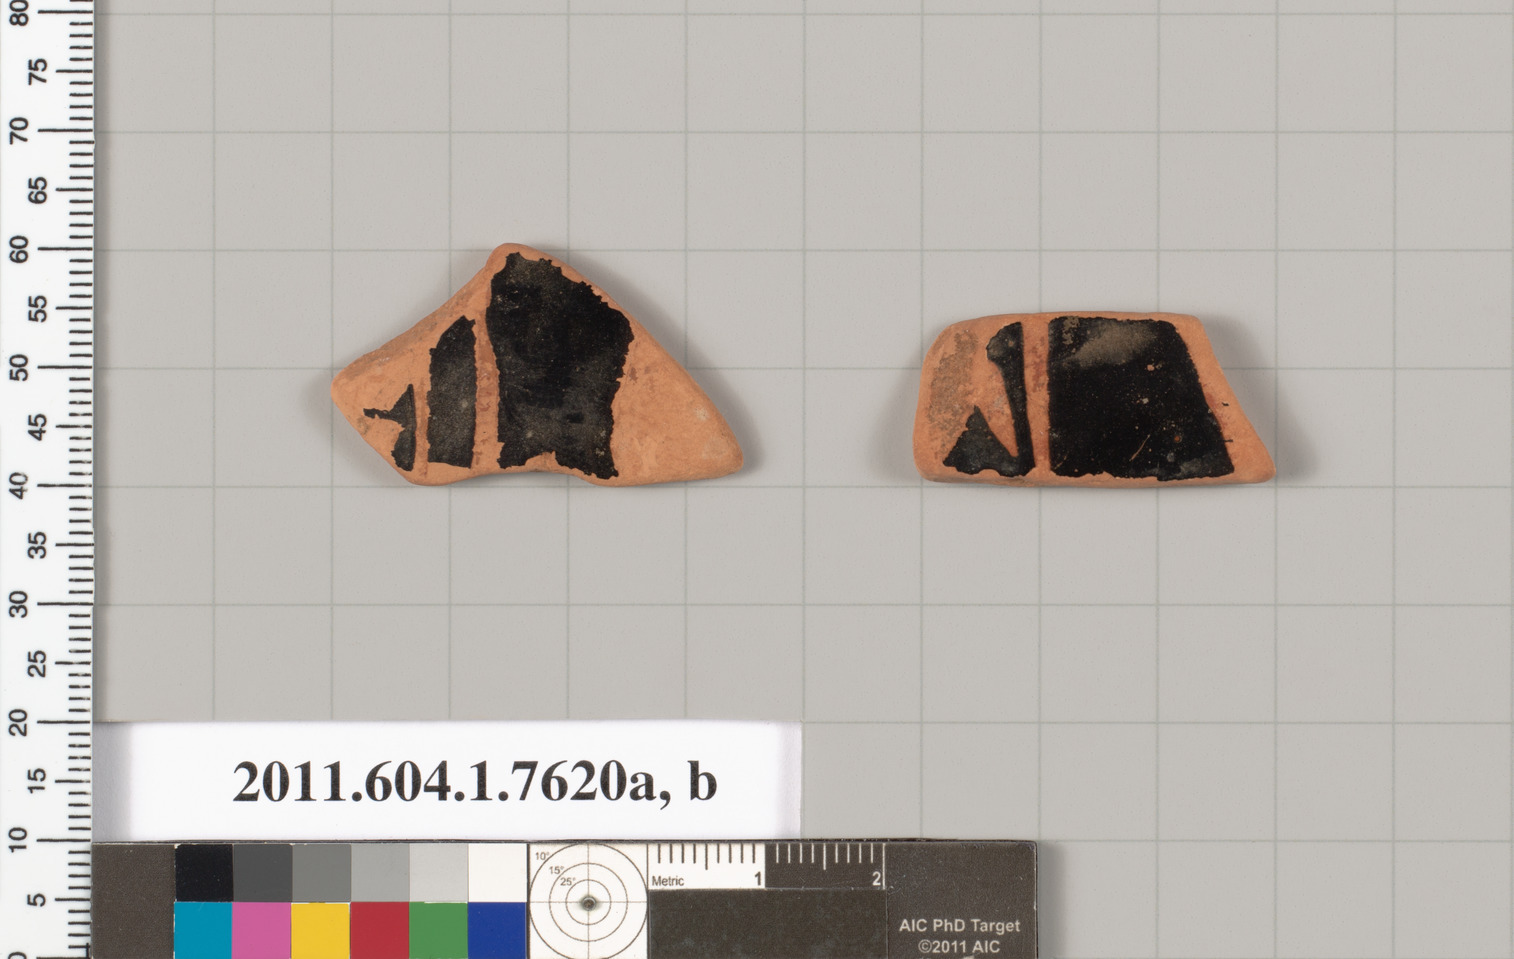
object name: kylix fragment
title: Terracotta fragments of kylikes (drinking cups)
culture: greek, attic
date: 460-450 BCE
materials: terracotta